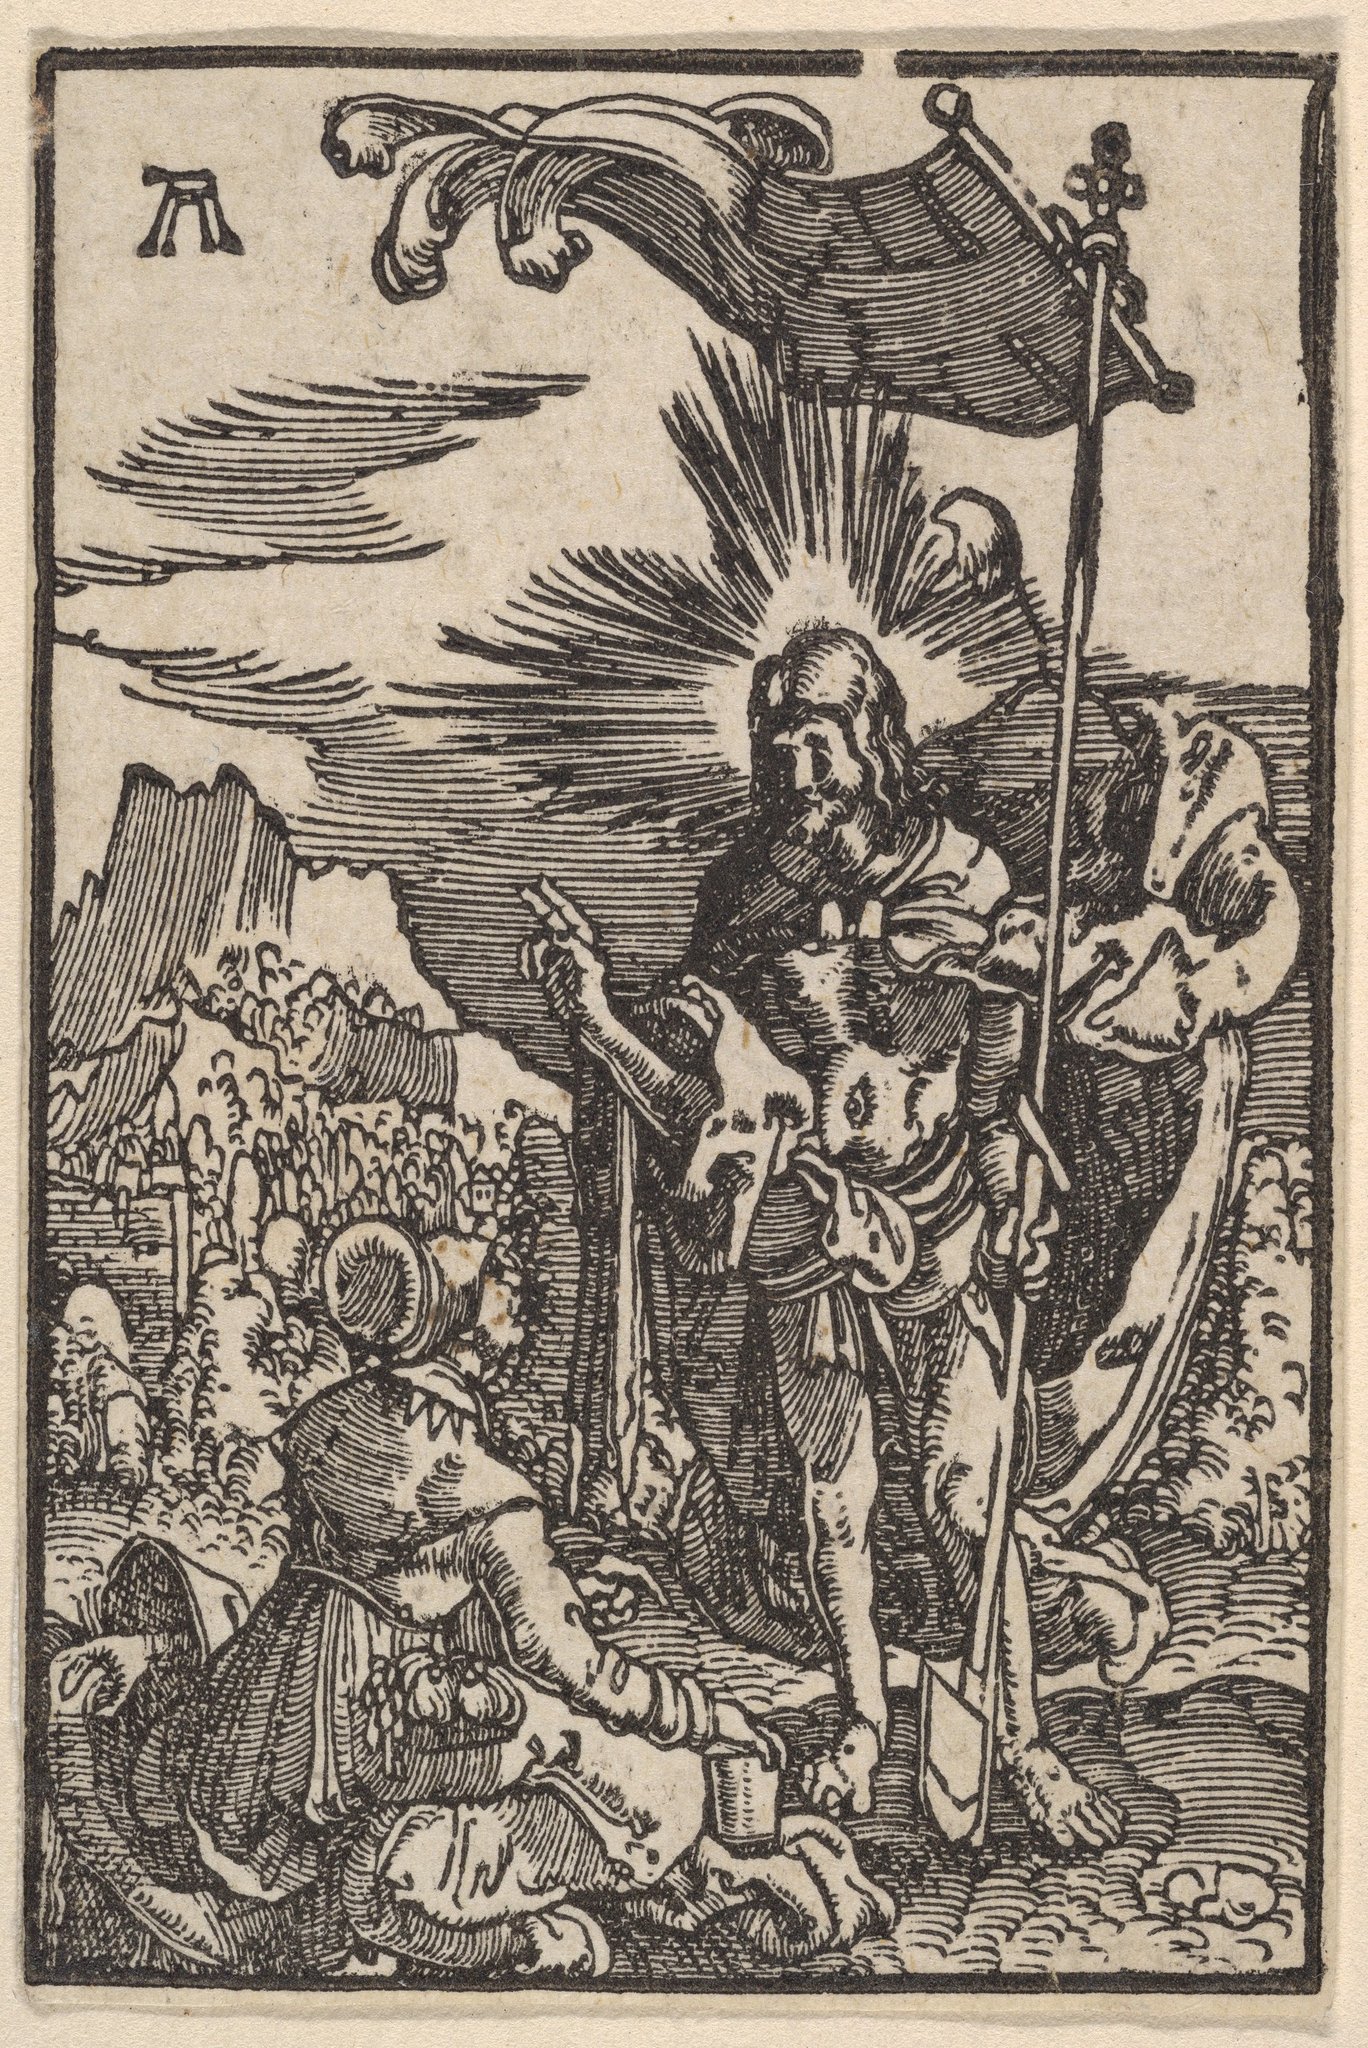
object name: print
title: Noli Me Tangere, from "The Fall and Salvation of Mankind Through the Life and Passion of Christ"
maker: albrecht altdorfer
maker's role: artist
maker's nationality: german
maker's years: 1480-1538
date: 1513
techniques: woodcut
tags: women,christ,crowd,flags